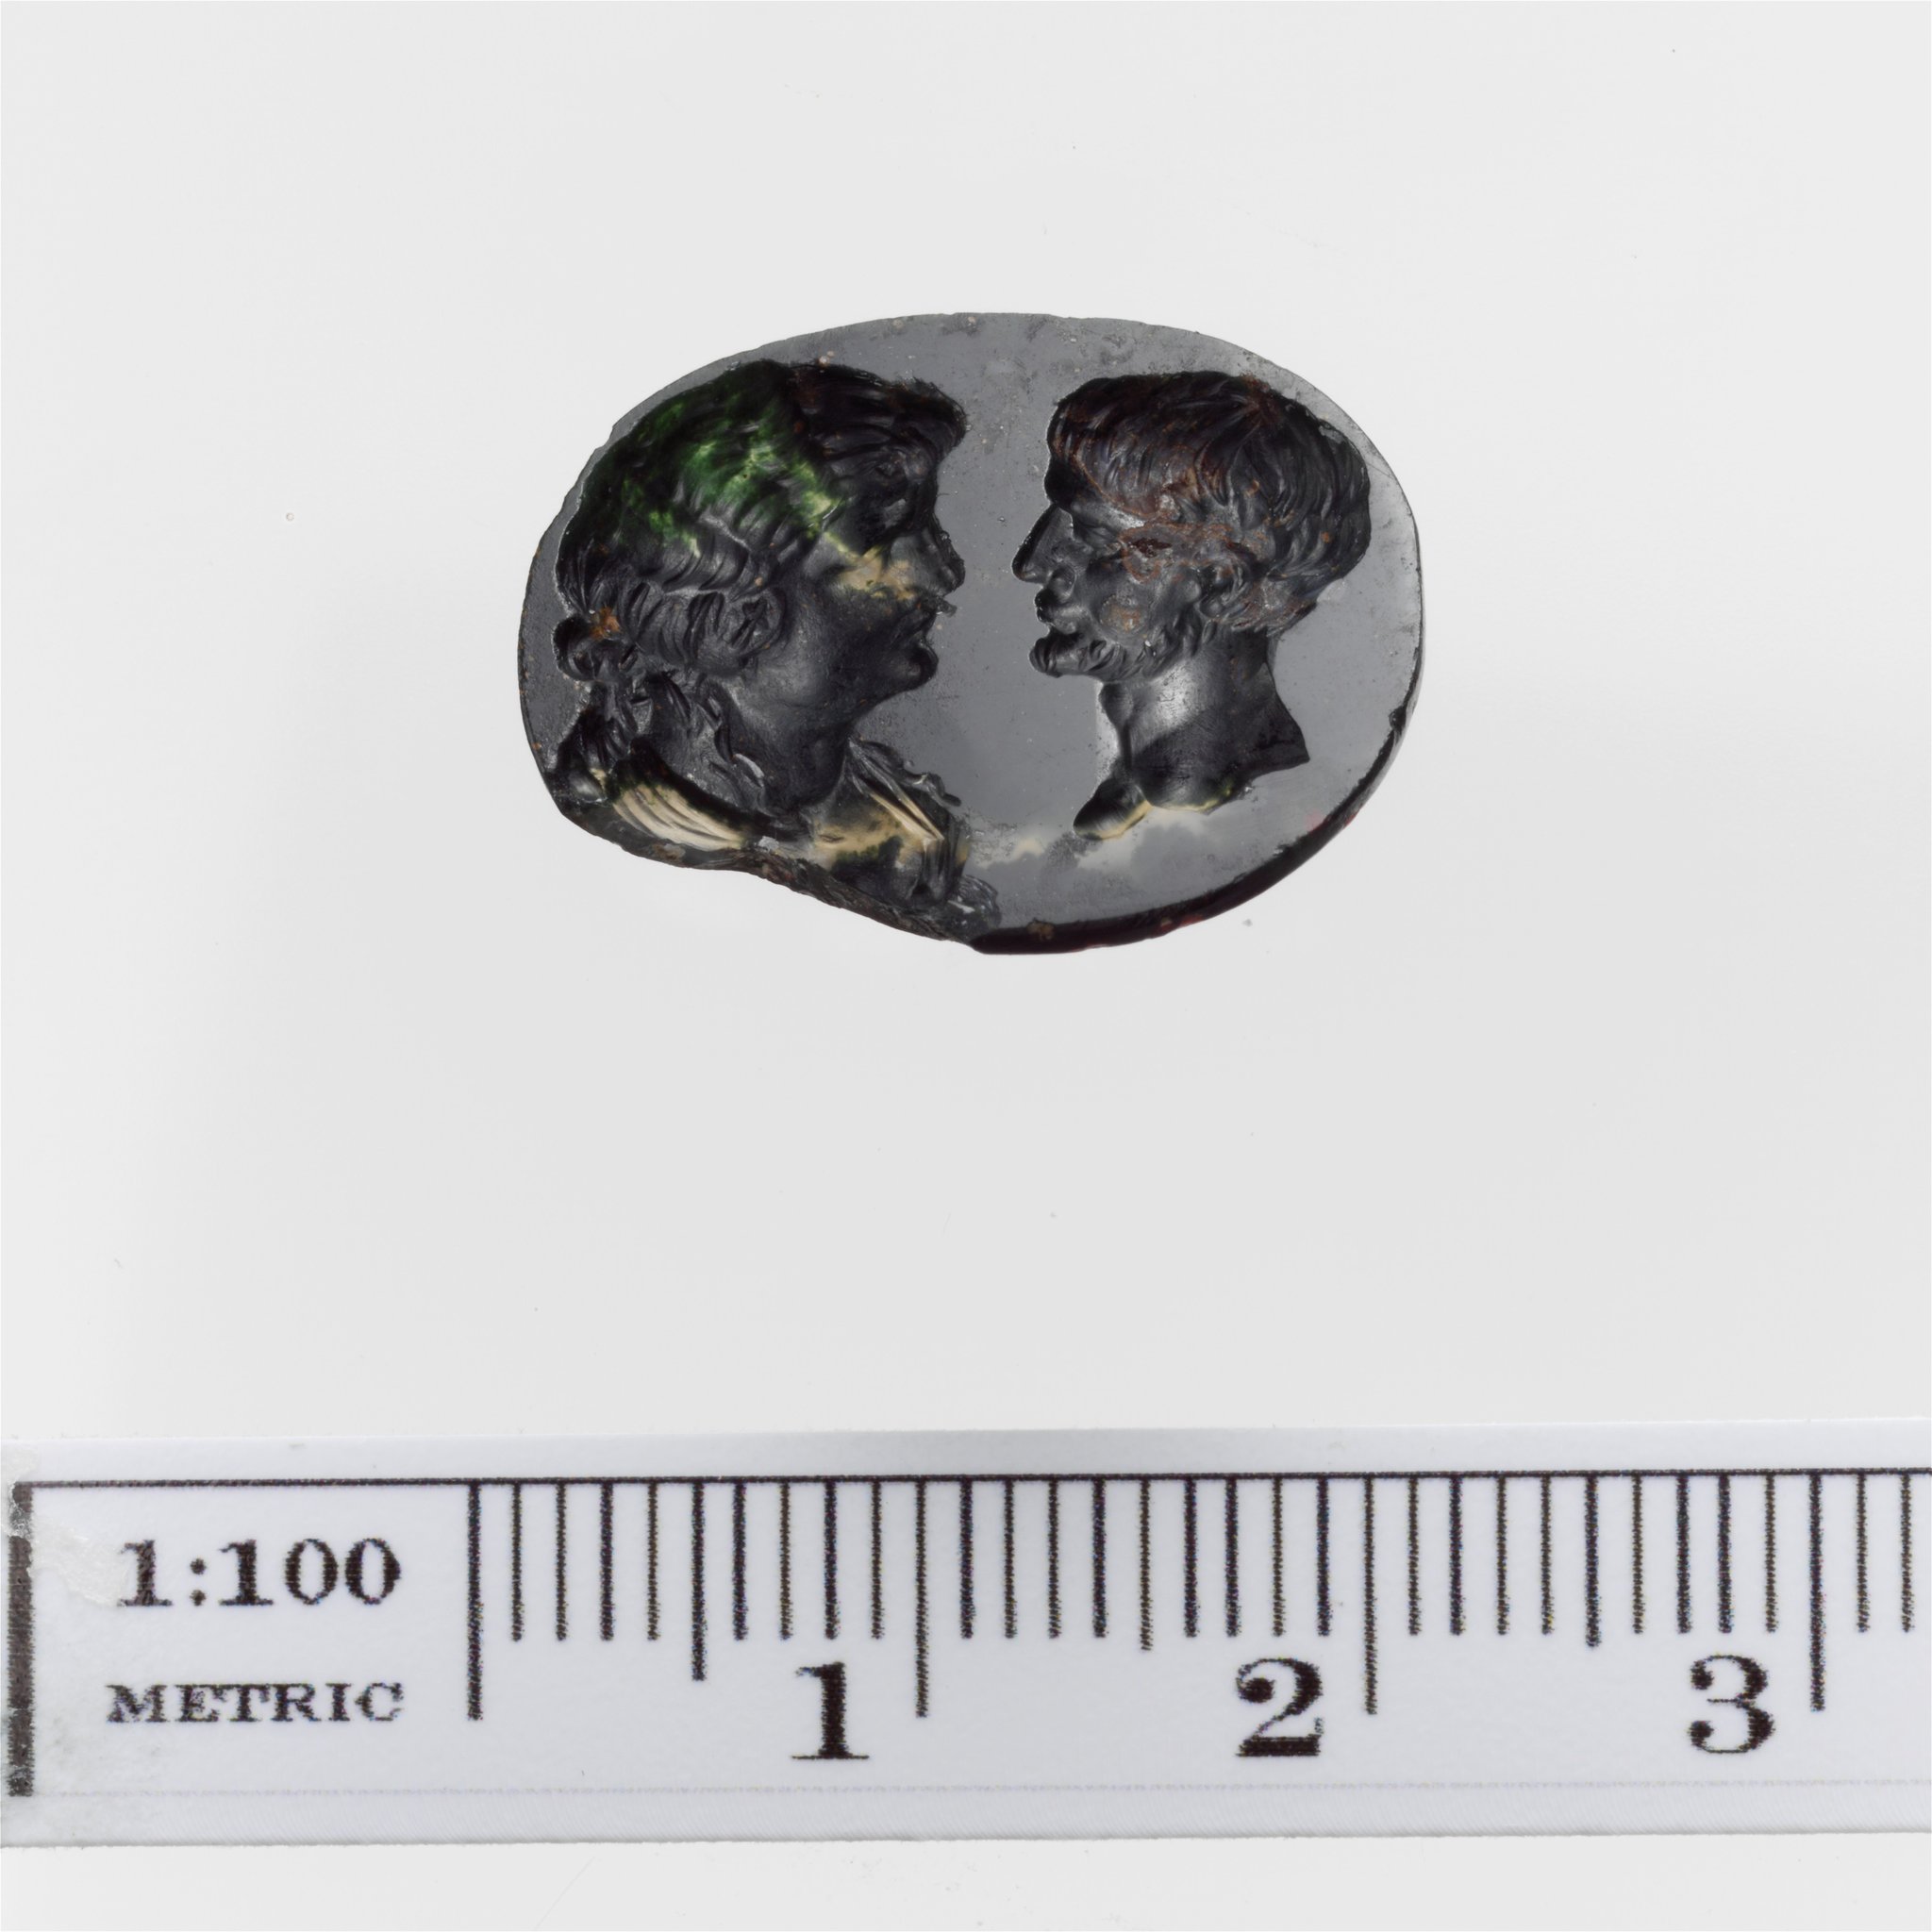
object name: intaglio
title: Moss agate ring stone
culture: roman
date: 101-200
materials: stone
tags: men,women